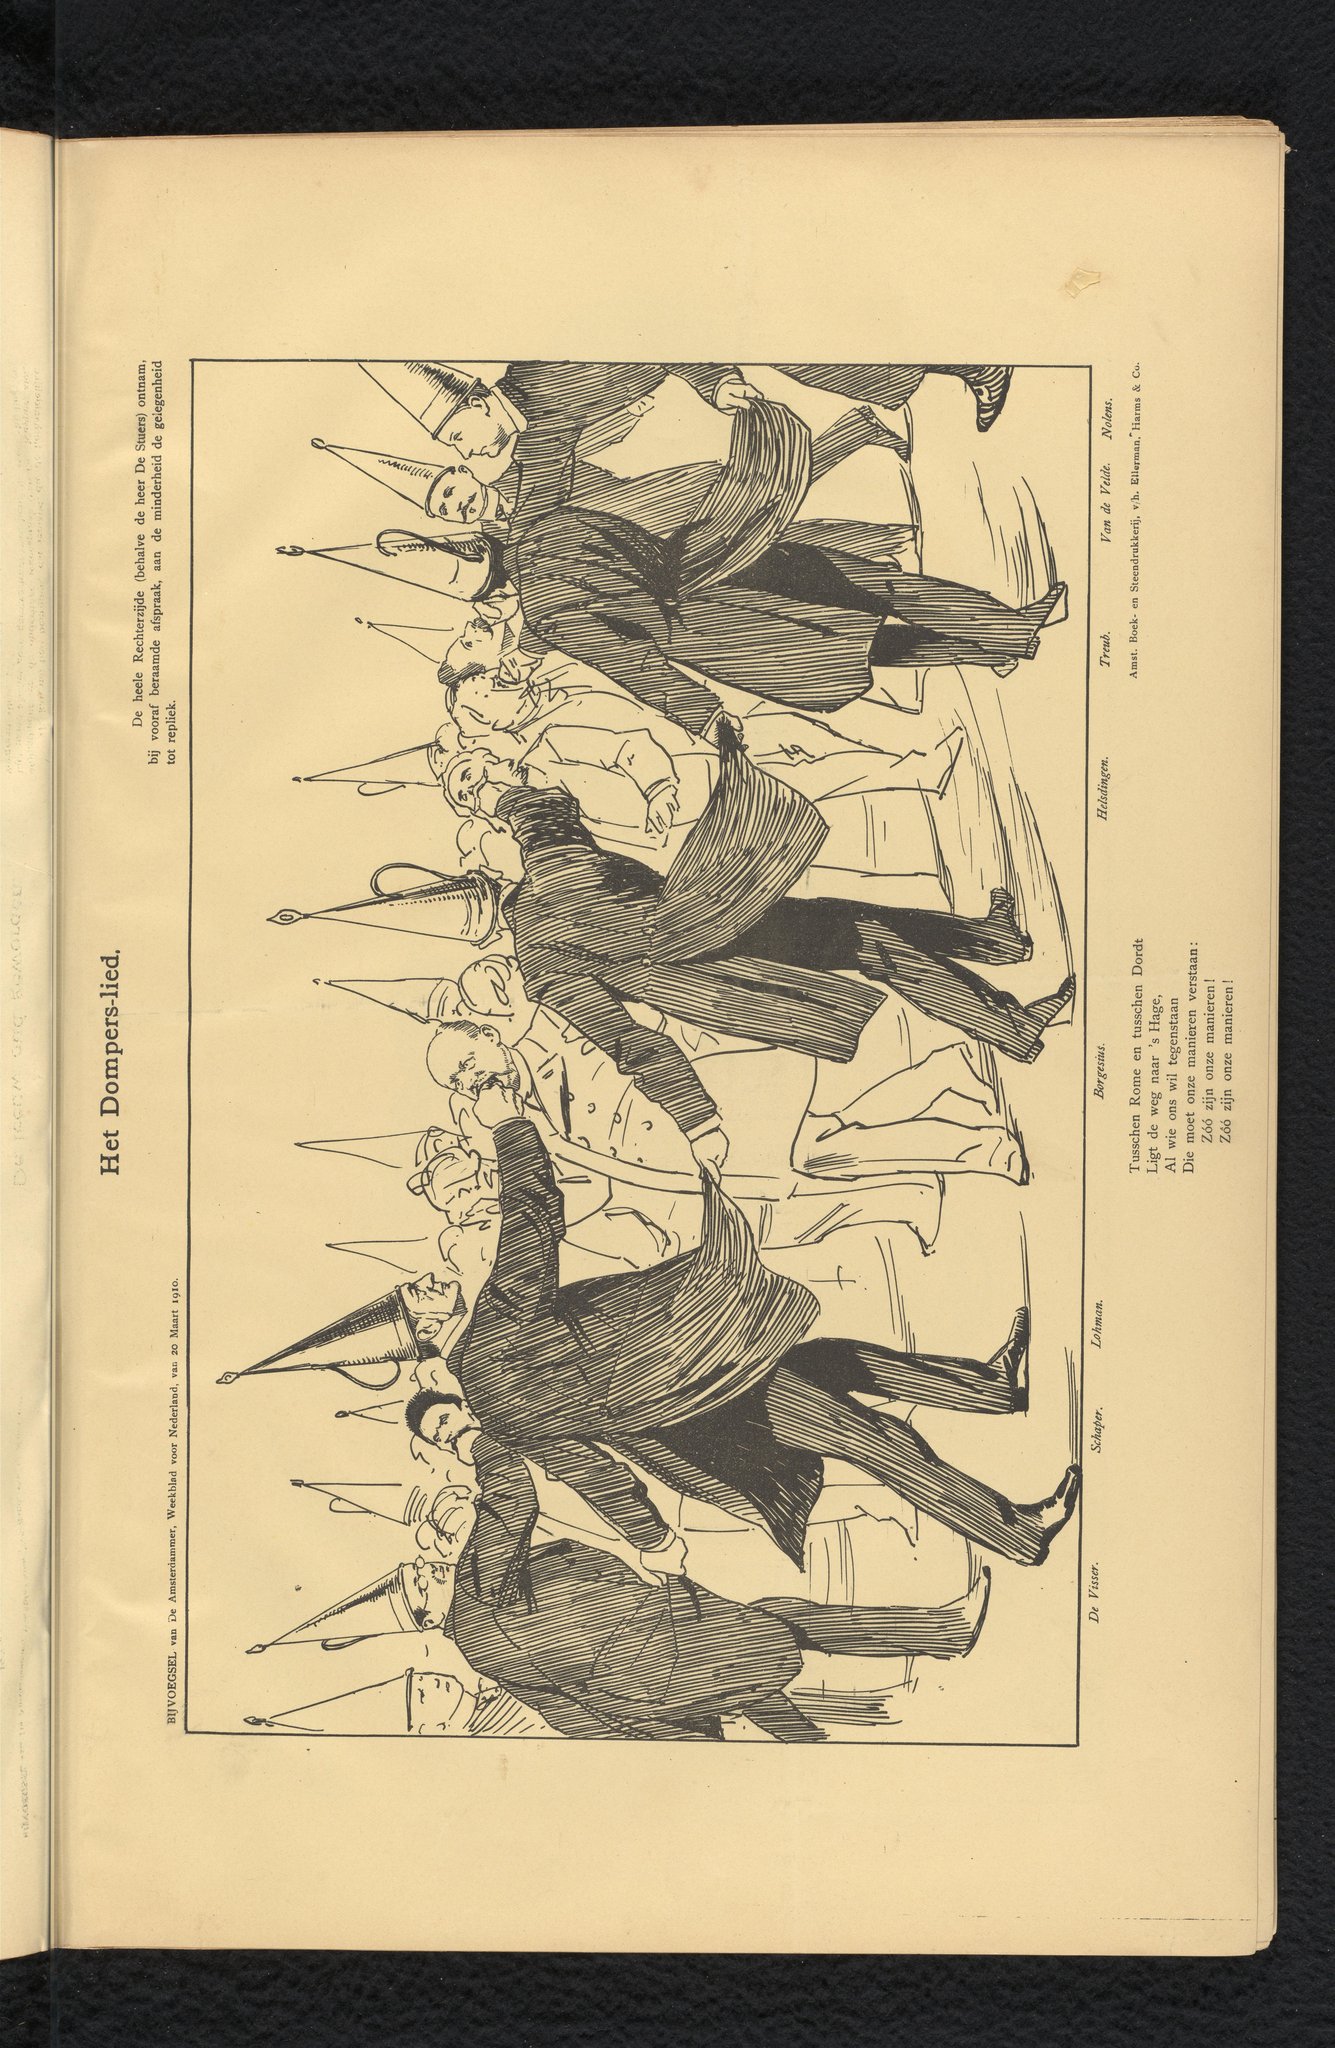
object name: cartoon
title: Het Dompers-lied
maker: johan braakensiek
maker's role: draughtsman, print maker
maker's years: 1858-1940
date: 1910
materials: paper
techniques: lithograph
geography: netherlands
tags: rotterdam, dutch east indies, the, the hague, jonkheer alexander frederik de savornin lohman, priest, voorschoten, utrecht, politician, snuffers, debate, discussion (~ parliament), political caricatures and satires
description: Tweede Kamerleden ter rechterzijde voorkomen dat in het debat andere Kamerleden het woord kunnen nemen. De Kamerleden voorgesteld met kaarsendompers op hun hoofd die hun vuisten in de monden van de anderen steken zodat ze niet kunnen spreken. Onderaan de tekst van het 'dompers-lied'.